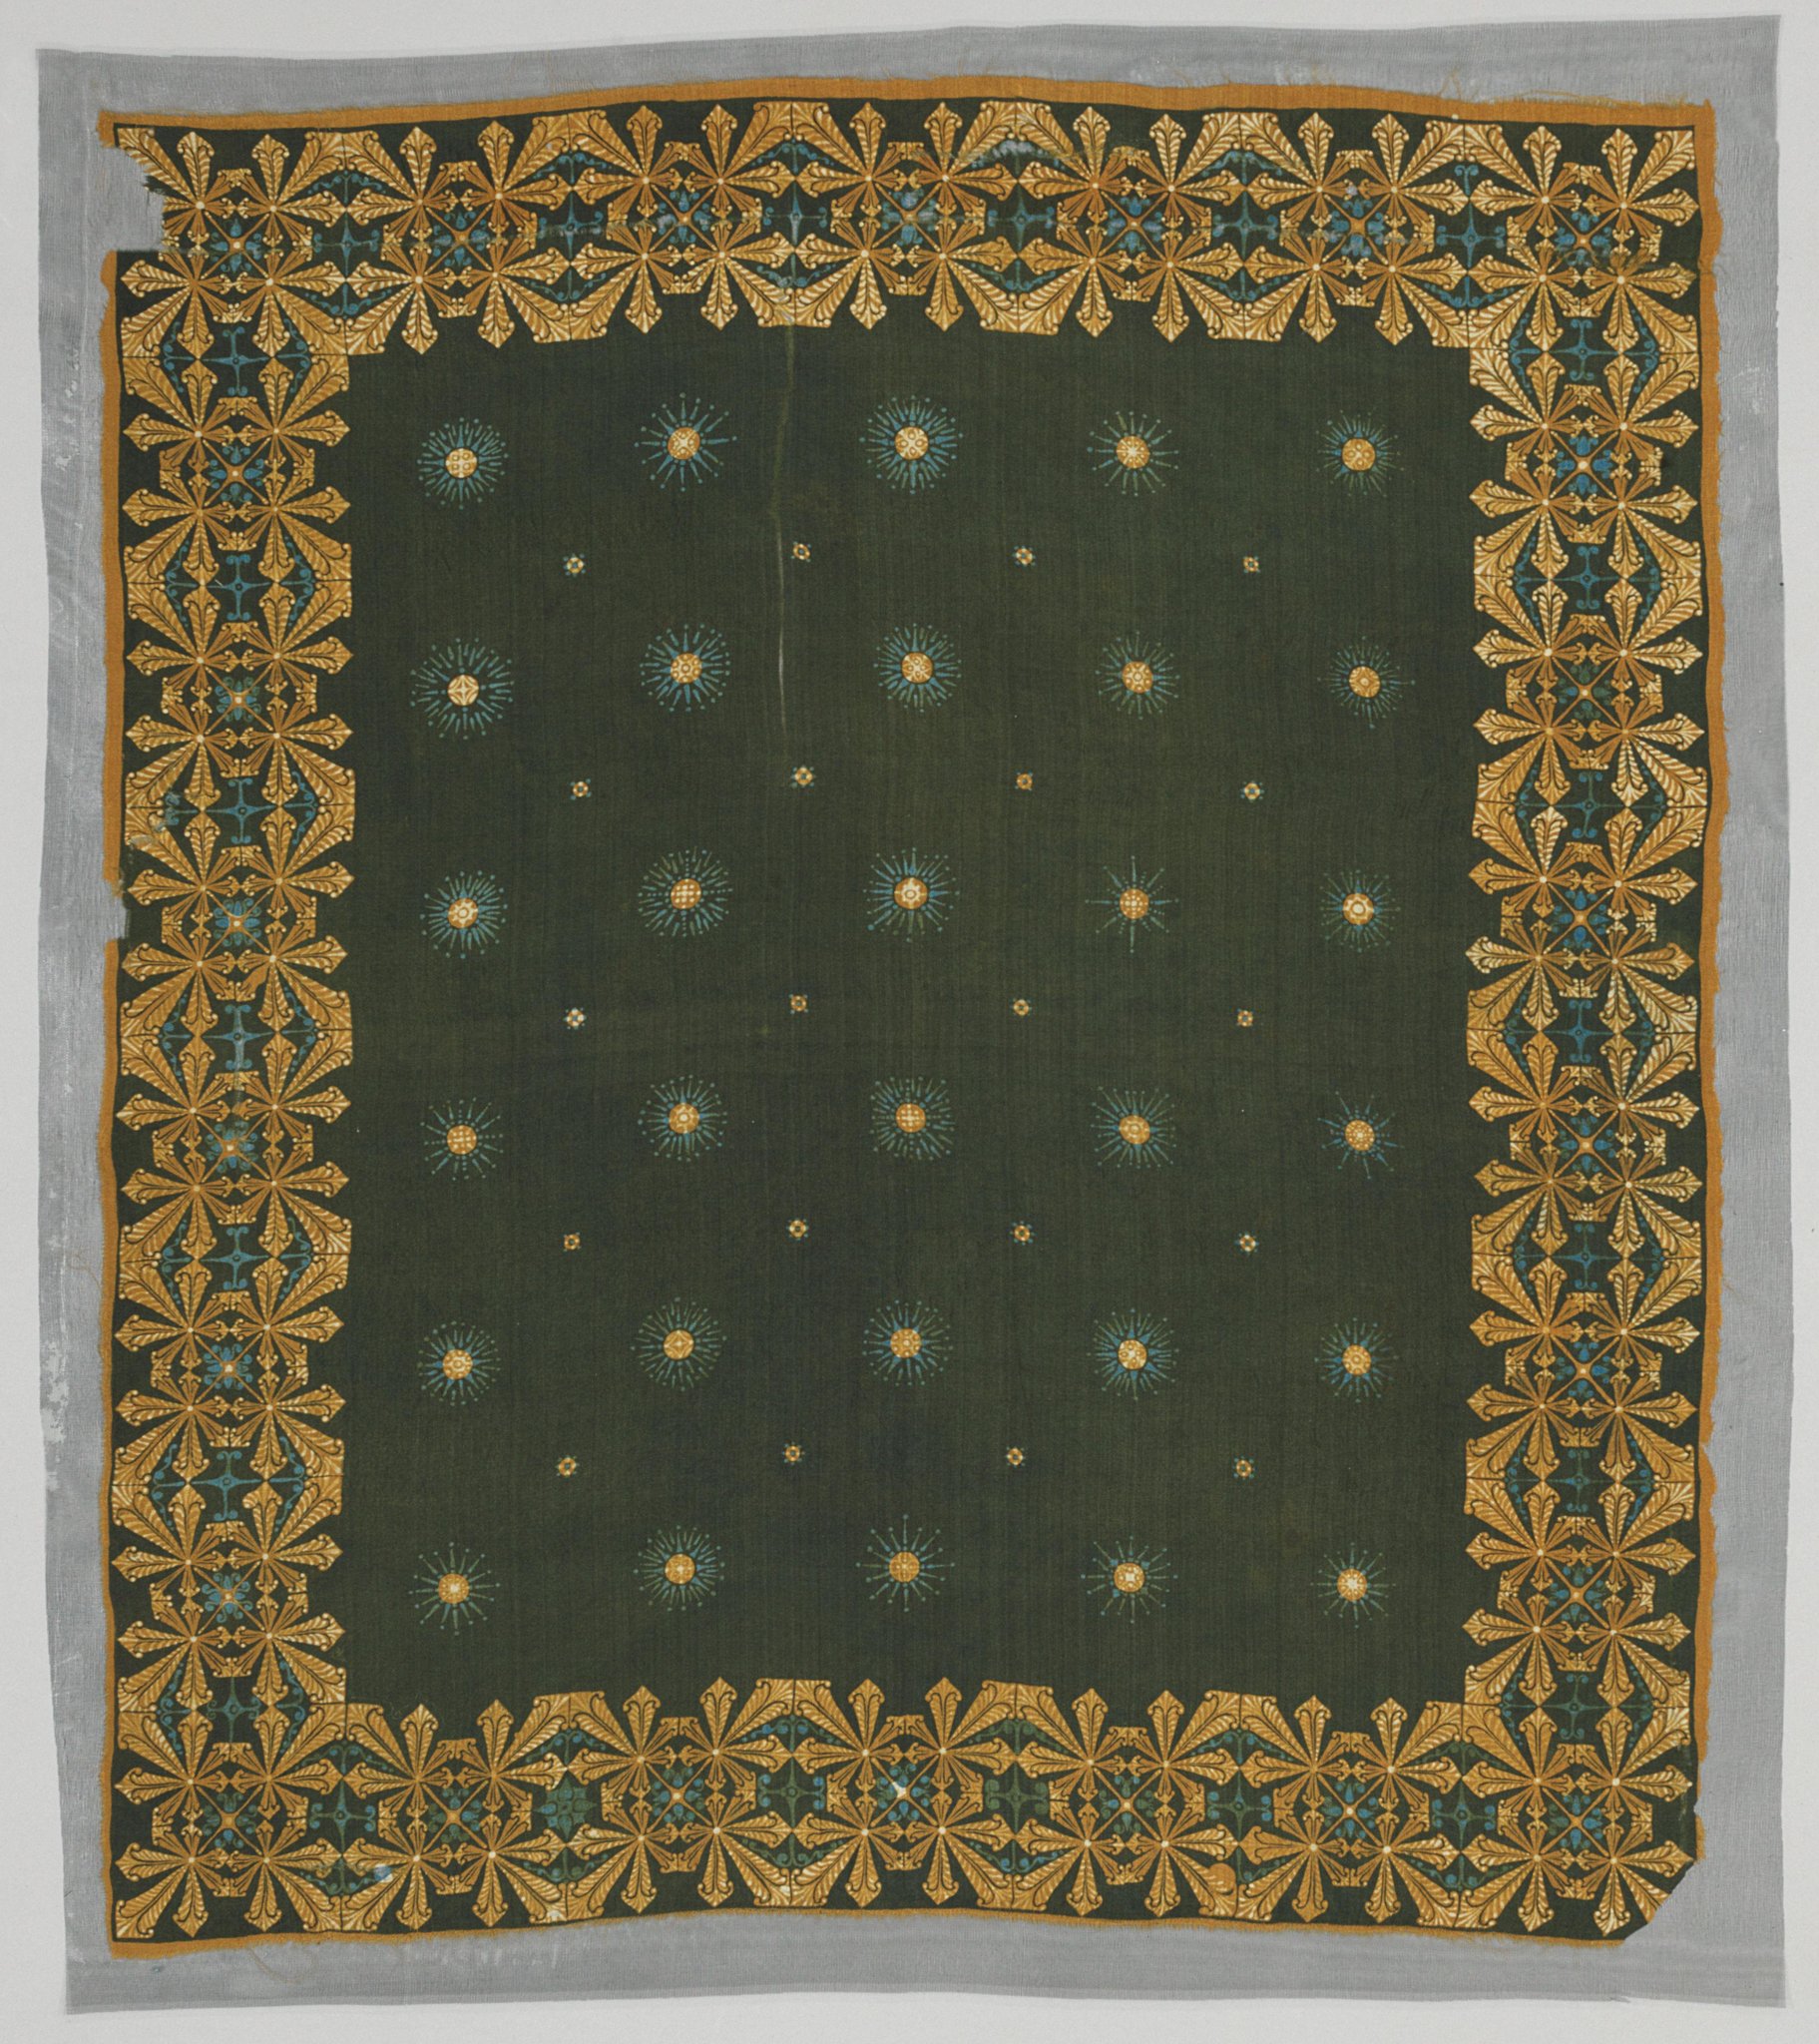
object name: panel ornament area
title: Paneel van een scherm van gebatikte zijde met patroon van kastanjebladeren en -bloemen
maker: chris lebeau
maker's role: draughtsman, print maker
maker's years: 1878-1945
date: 1905-1910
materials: silk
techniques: batik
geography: haarlem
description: Paneel van een scherm van gebatikte zijde met randpatroon van kastanjebladeren en een middenveld bezaaid met kastanjebloemen en gestileerde motieven.